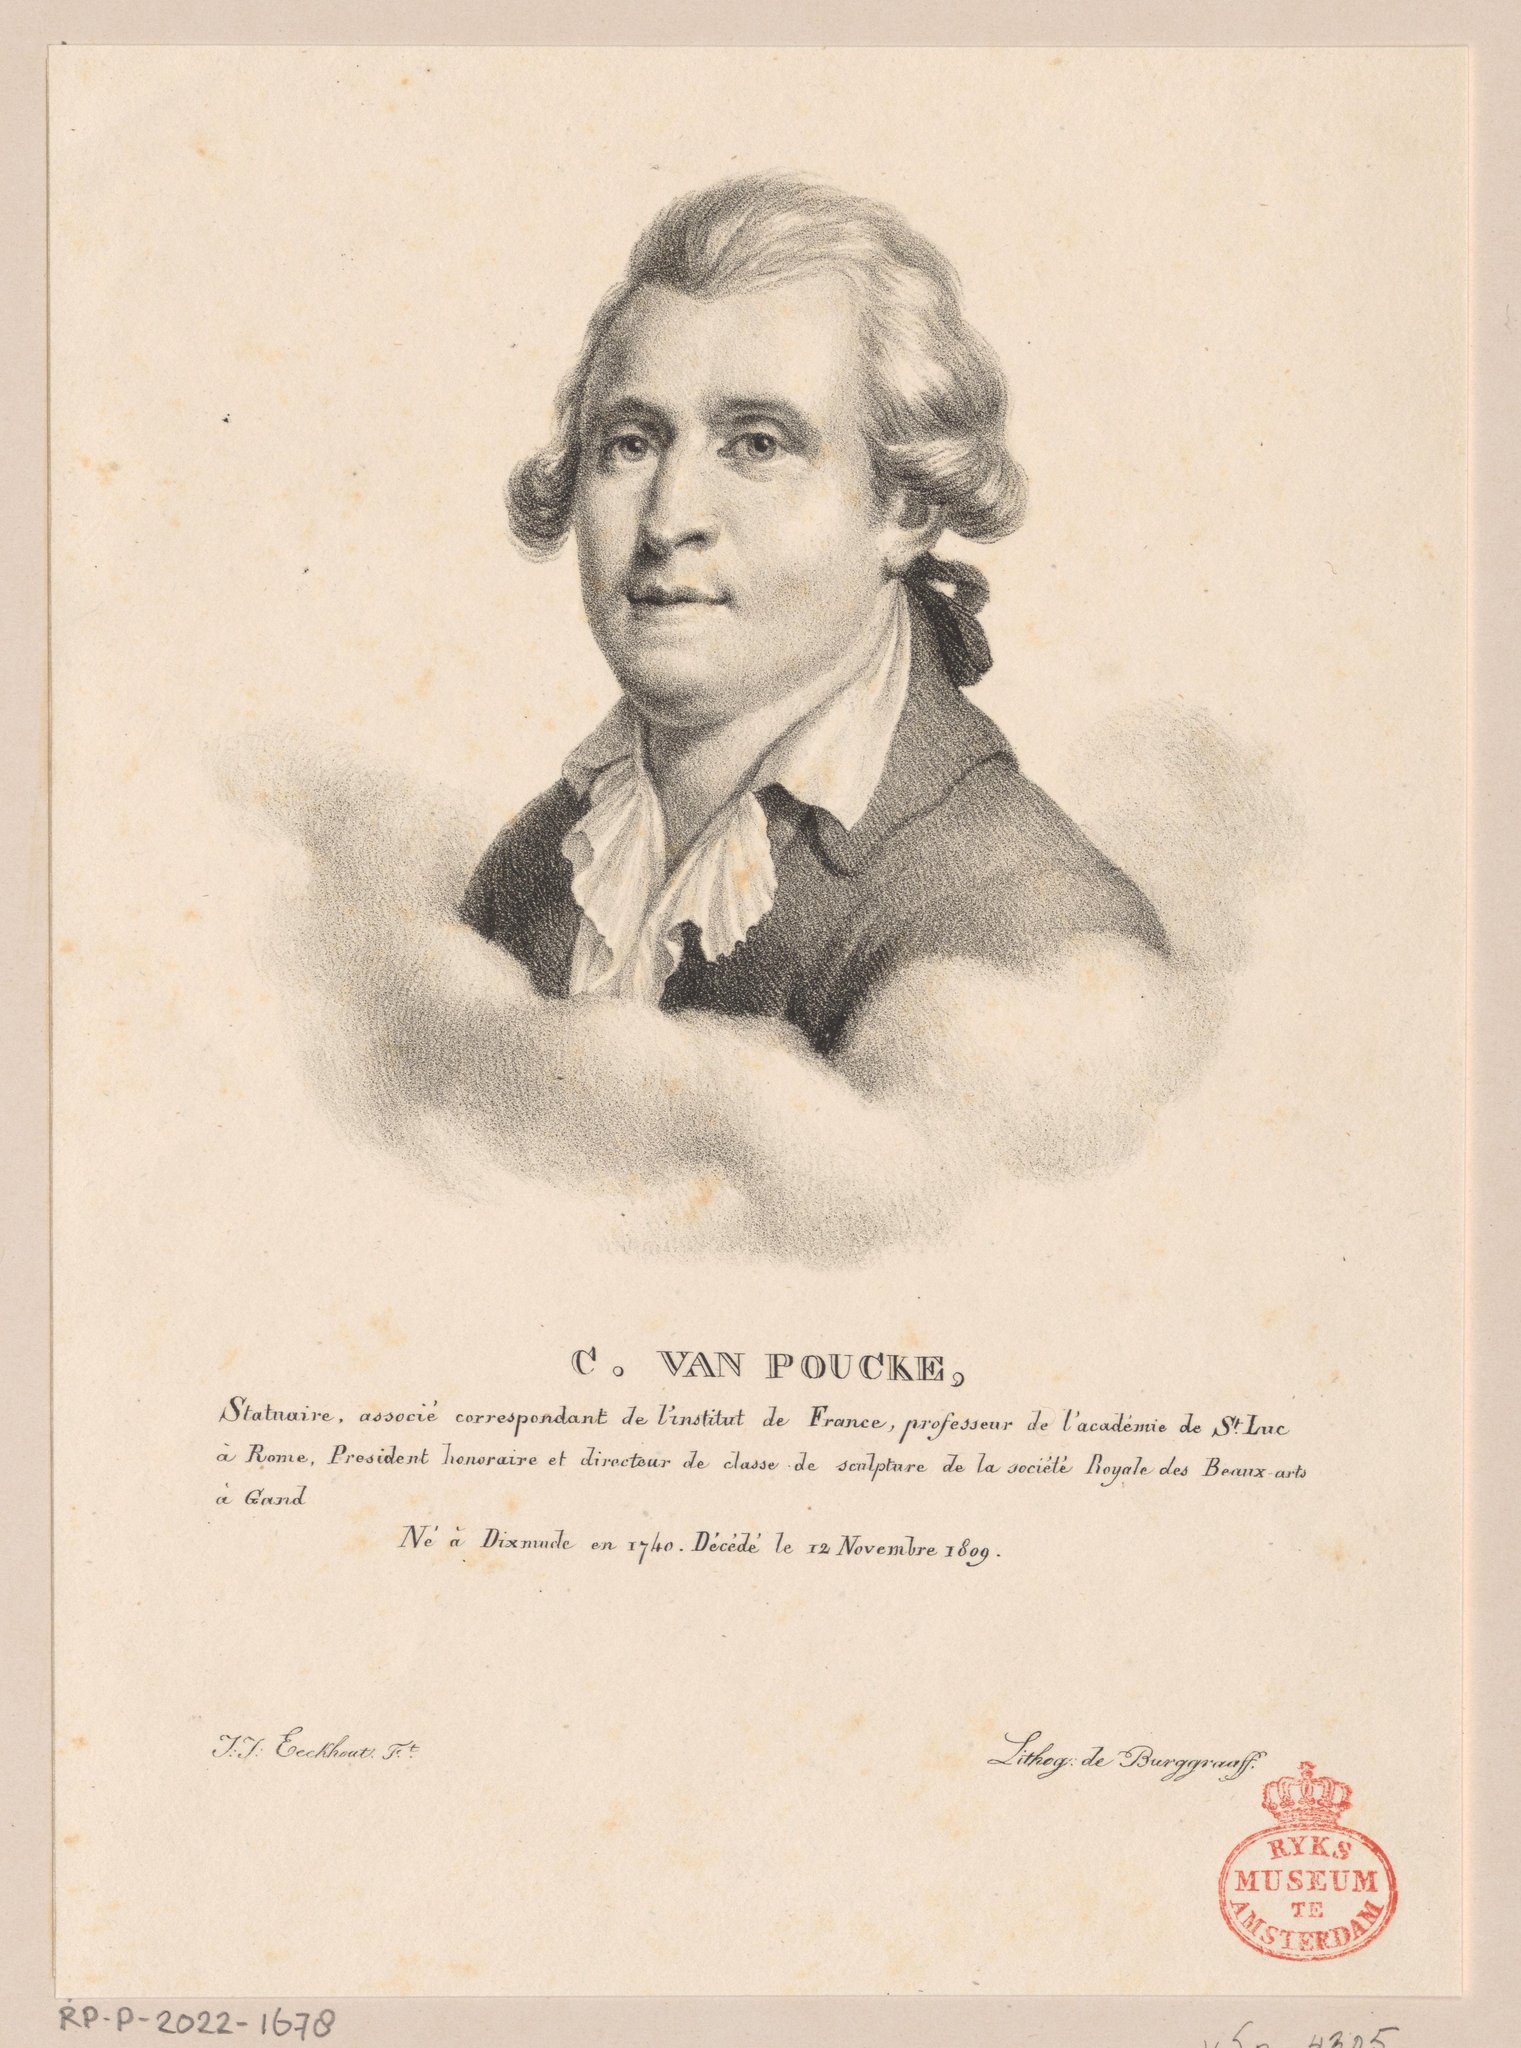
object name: print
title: Portretten van hedendaagse kunstenaars uit het Verenigd Koninkrijk der Nederlanden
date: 1822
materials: paper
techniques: lithograph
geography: brussels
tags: ghent, sculptor, portrait, self-portrait of sculptor, historical persons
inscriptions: collector's mark: Lugt 12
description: Prent maakt deel uit van de serie: Eeckhout, Jacques J. en G.P. van den Burggraaff. Collection de Portraits Des Artistes Modernes, Nés Dans Le Royaume Des Pays-Bas. Brussel: s.n., 1822.